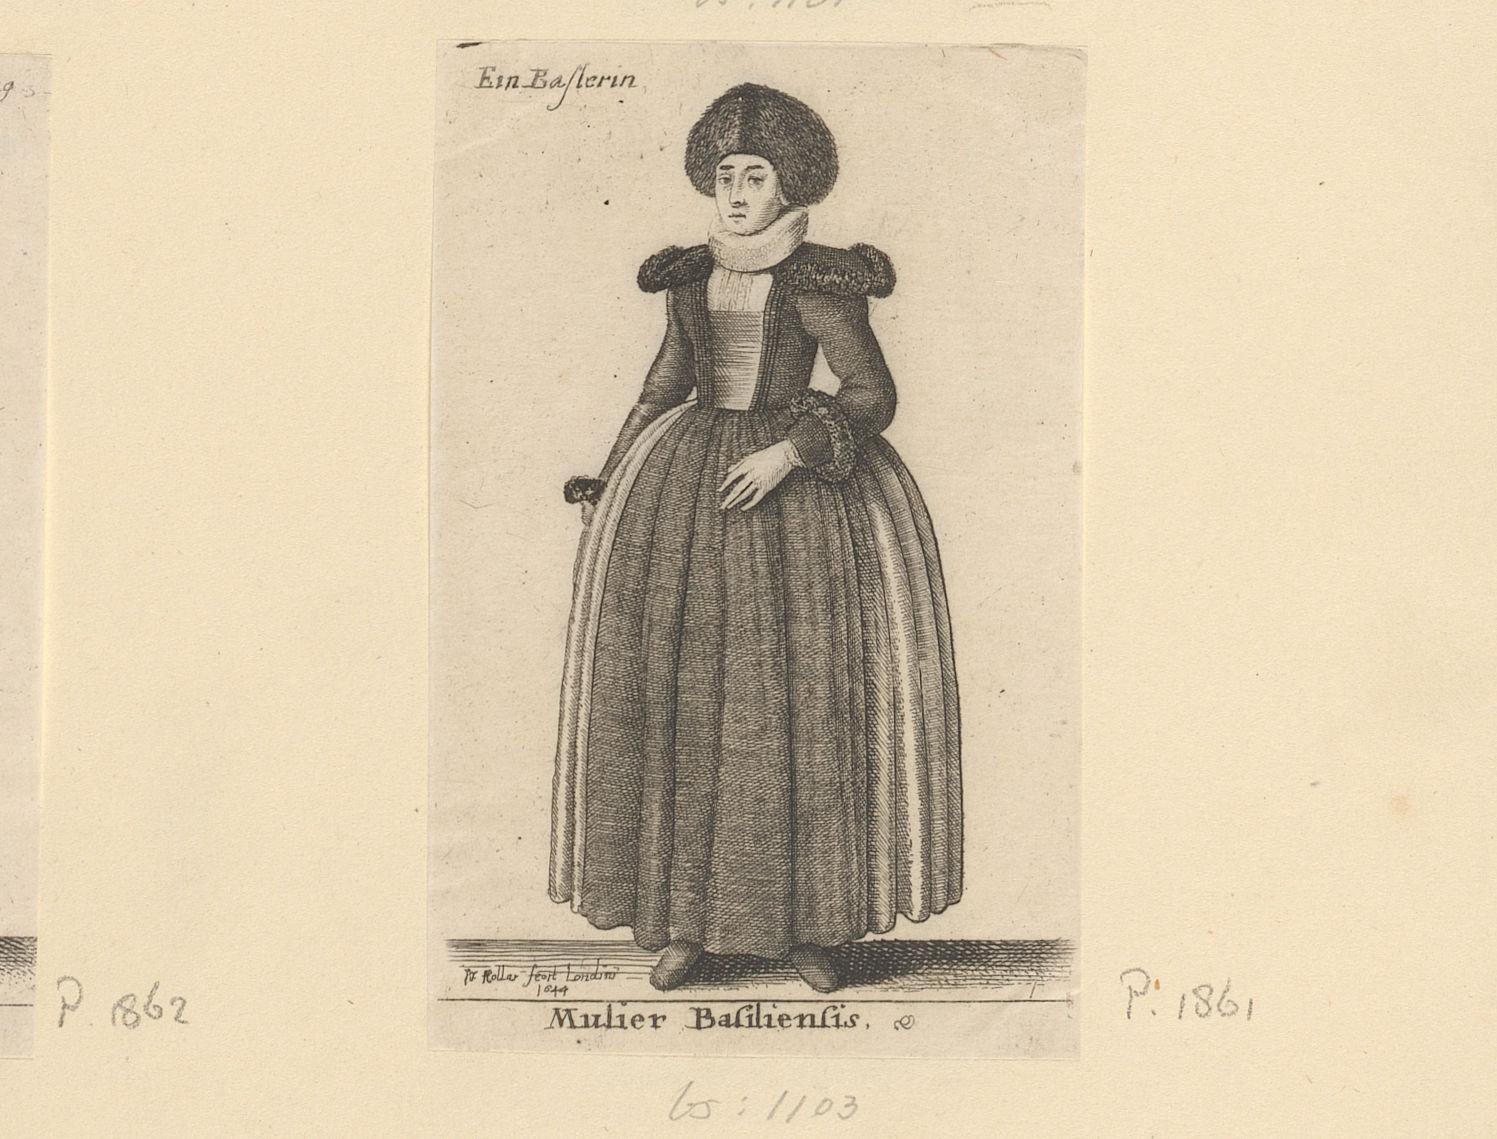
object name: print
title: Vrouw in klederdracht uit Basel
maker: wenceslaus hollar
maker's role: draughtsman, print maker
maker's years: 1607-1677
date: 1644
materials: paper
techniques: etching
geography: london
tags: adult woman, folk costume, regional costume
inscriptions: date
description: Prent maakt mogelijk deel uit van een serie van 200 prenten. Deze serie is onder de titel 'A Collection of two hundred original etchings' voor het eerst uitgegeven door J.M. Greery in 1816.